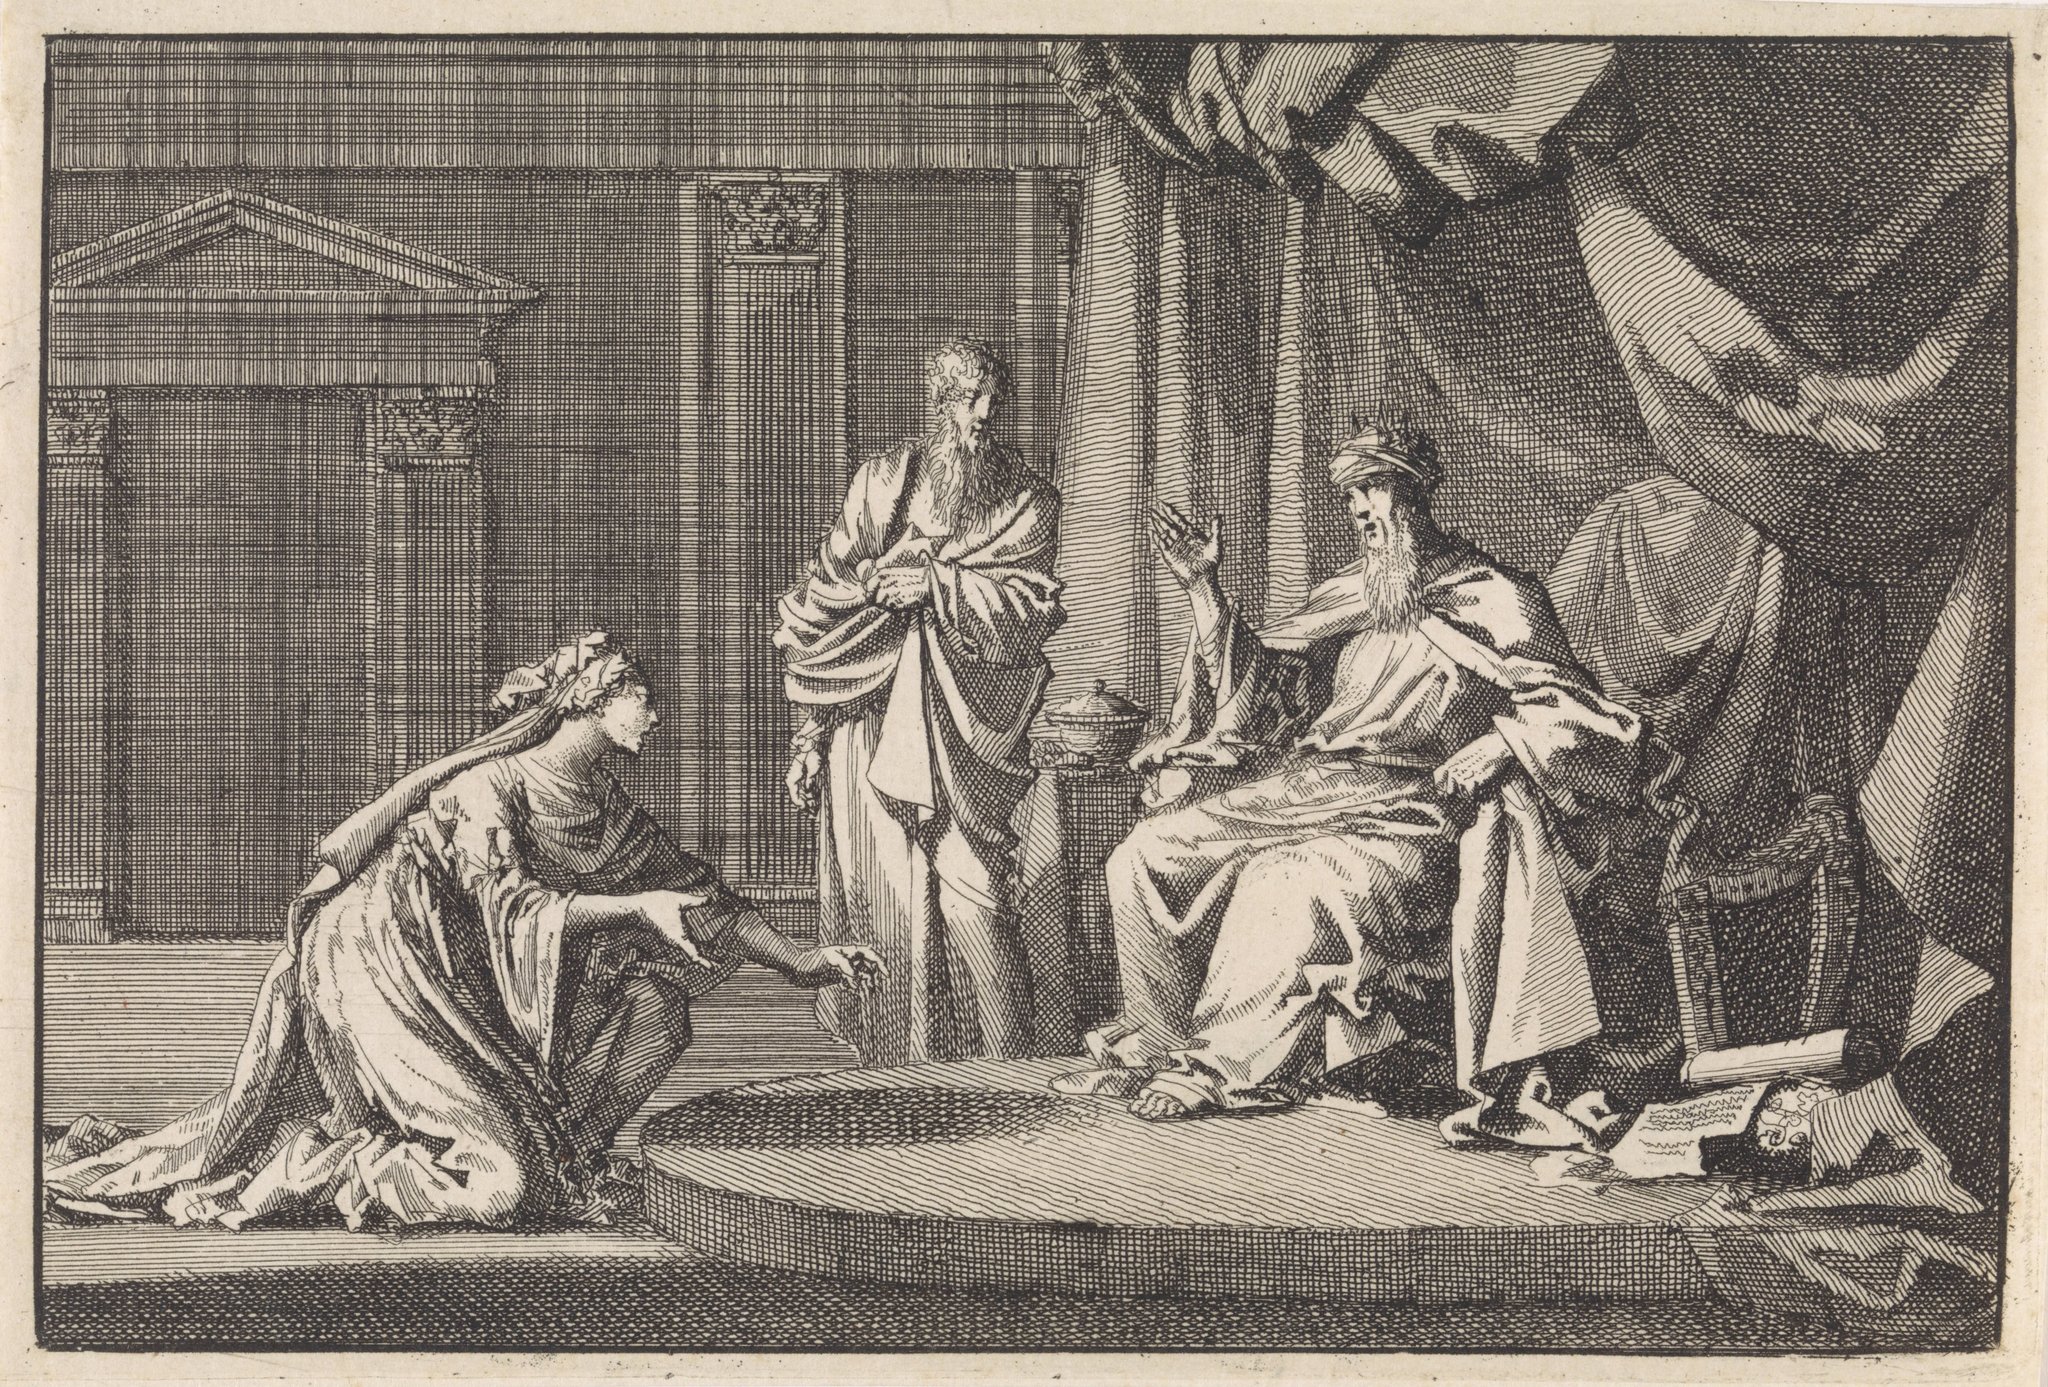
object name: print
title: Bathseba knielt voor David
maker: jan luyken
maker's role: draughtsman, print maker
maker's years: 1649-1712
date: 1704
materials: paper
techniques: etching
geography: amsterdam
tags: bathsheba comes to david's palace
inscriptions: collector's mark: Lugt 2228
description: Prent ook gebruikt als boekillustratie in: Josephus, Flavius. Alle de Werken, 2 delen. Amsterdam: Pieter Mortier, 1704, dl. 1, p. 180.